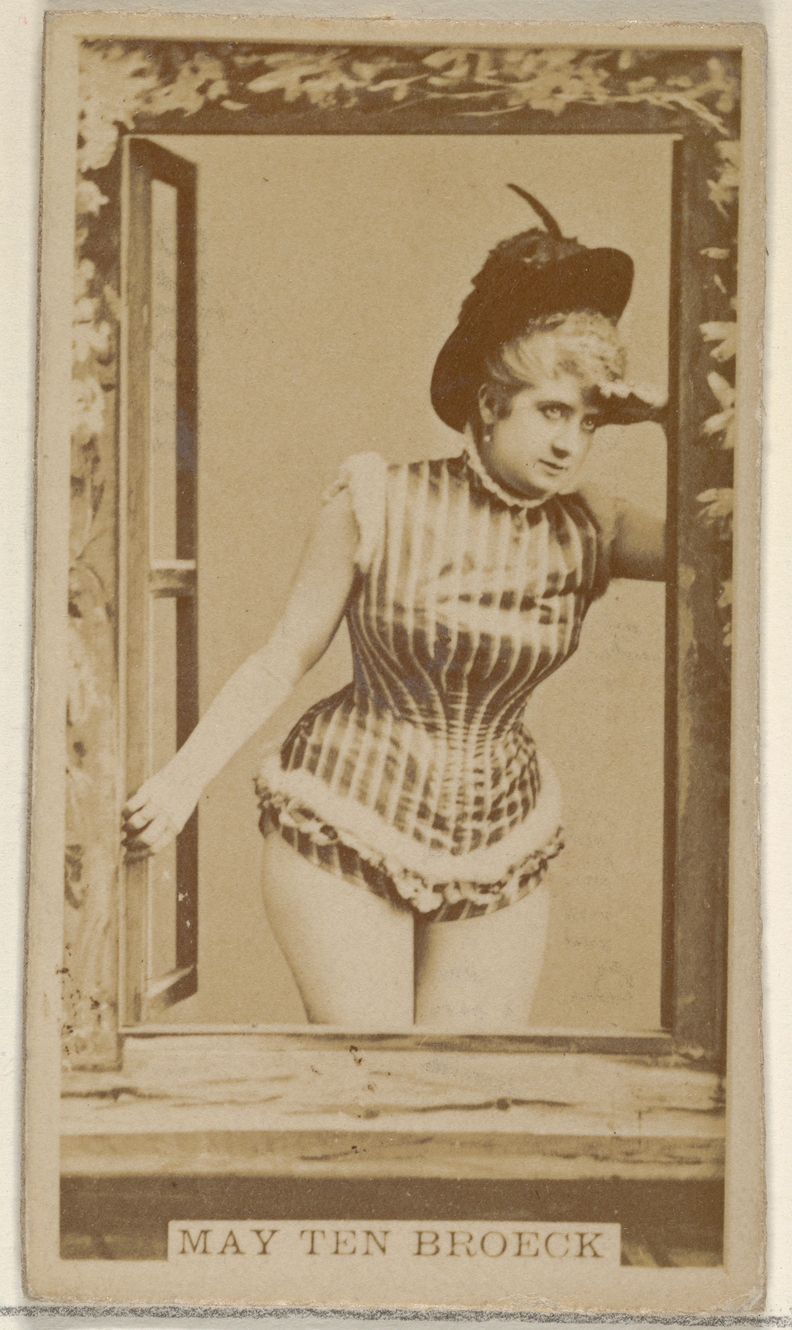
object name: photograph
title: May Ten Broeck, from the Actors and Actresses series (N45, Type 8) for Virginia Brights Cigarettes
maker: allen & ginter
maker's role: publisher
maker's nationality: american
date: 1888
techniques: albumen silver print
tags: portraits,women,actresses